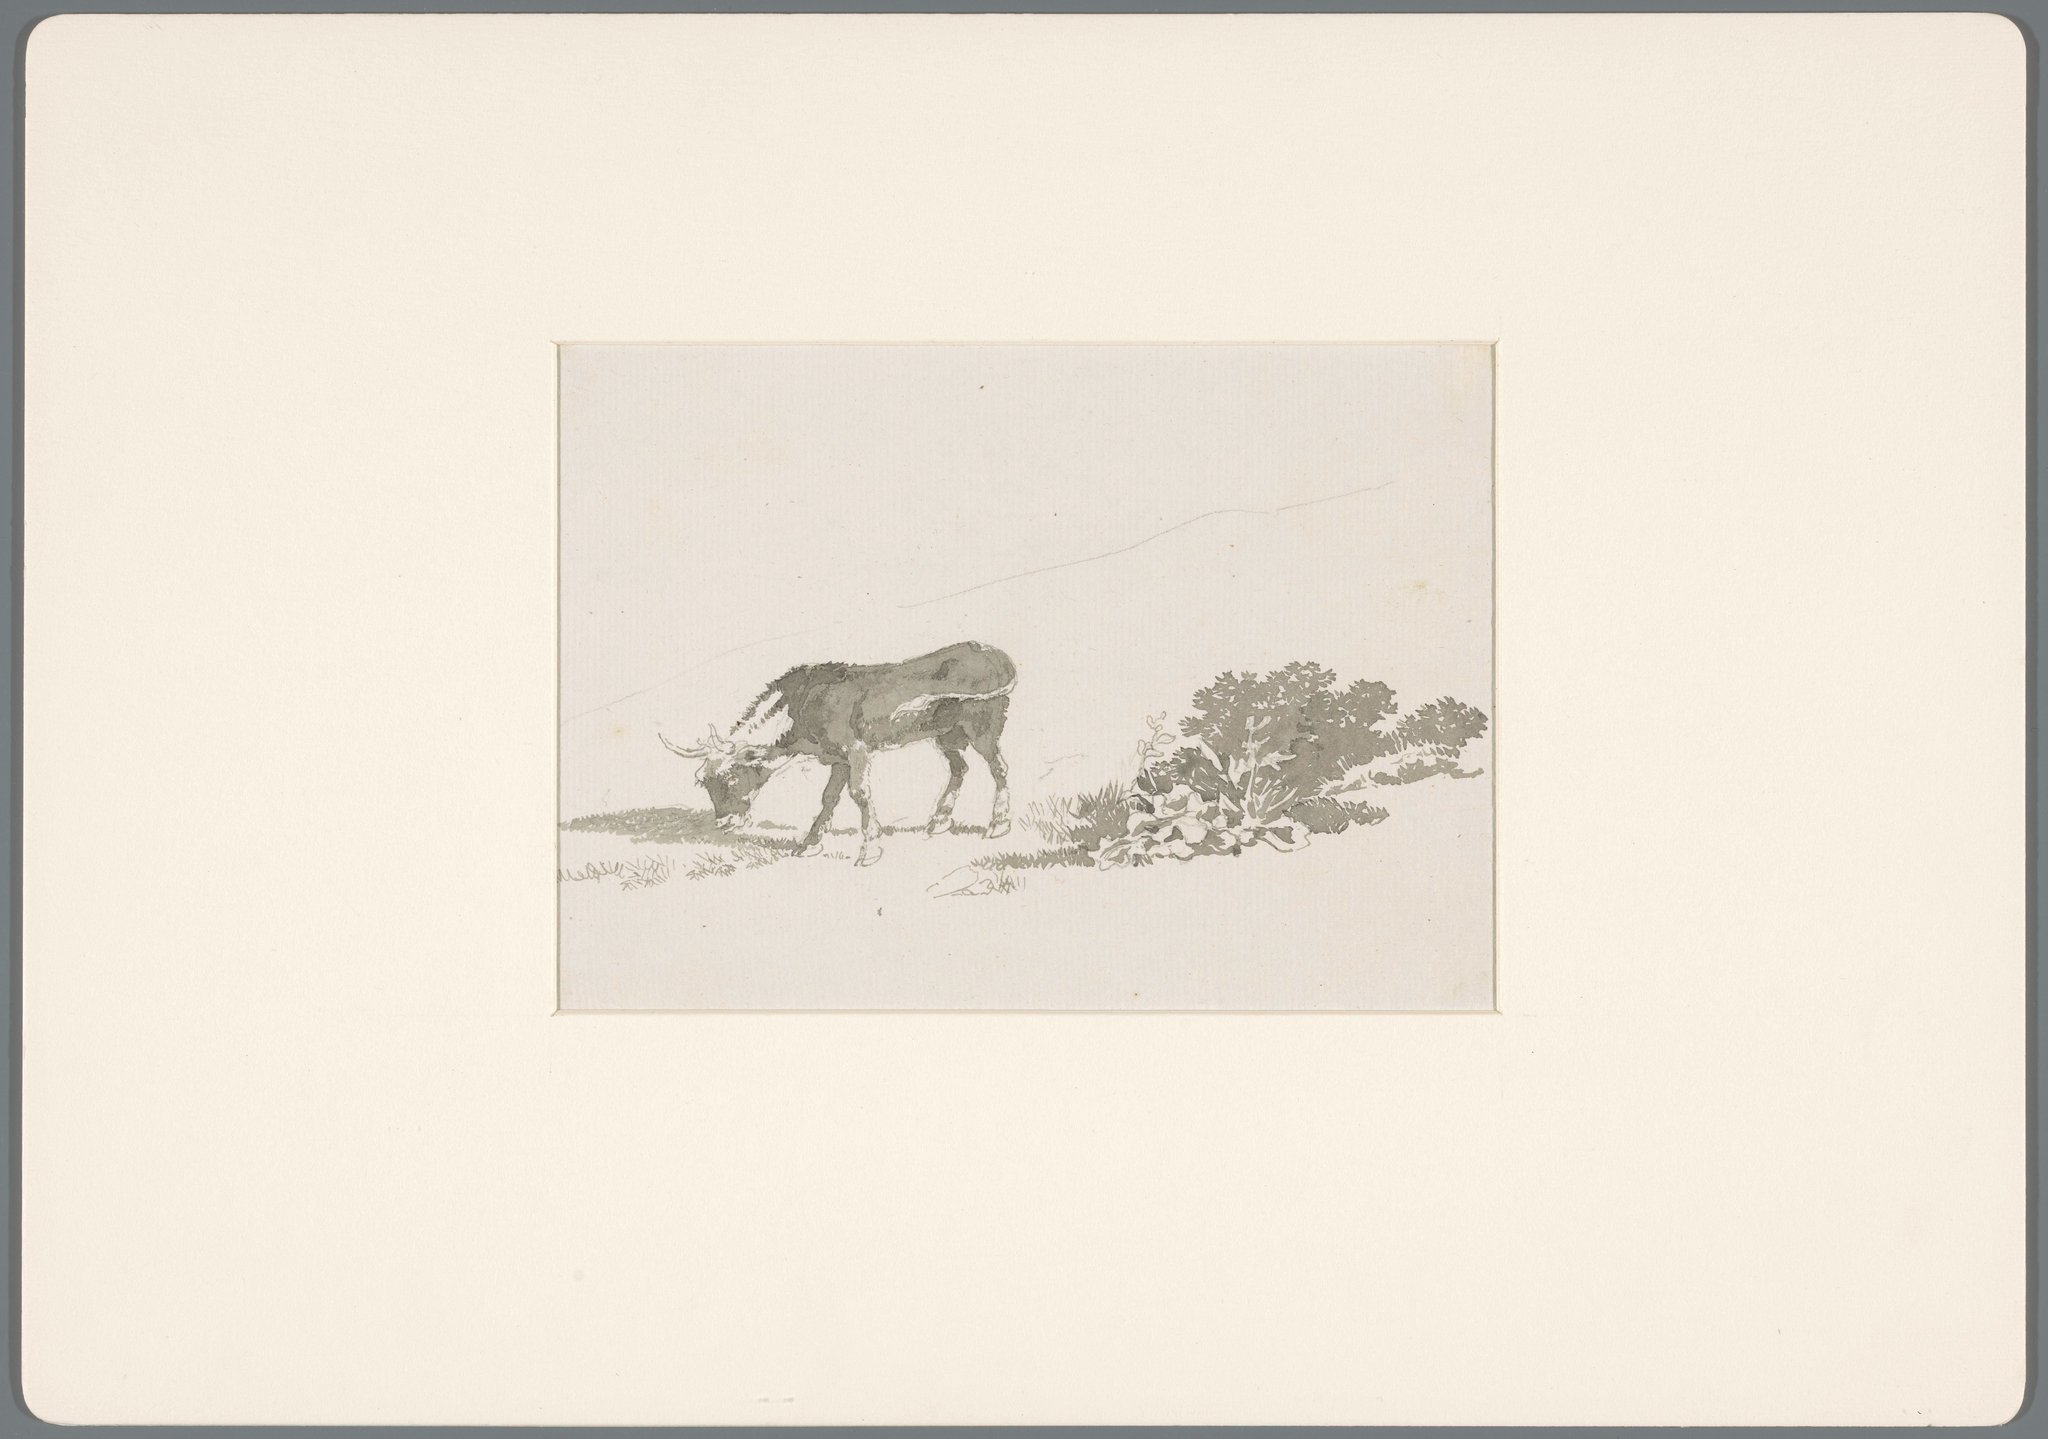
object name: drawing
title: Grazend kalf bij planten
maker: david alphonse de sandoz-rollin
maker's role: draughtsman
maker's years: 1740-1809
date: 1750-1809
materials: ink, paper, pencil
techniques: brush, pen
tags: calf